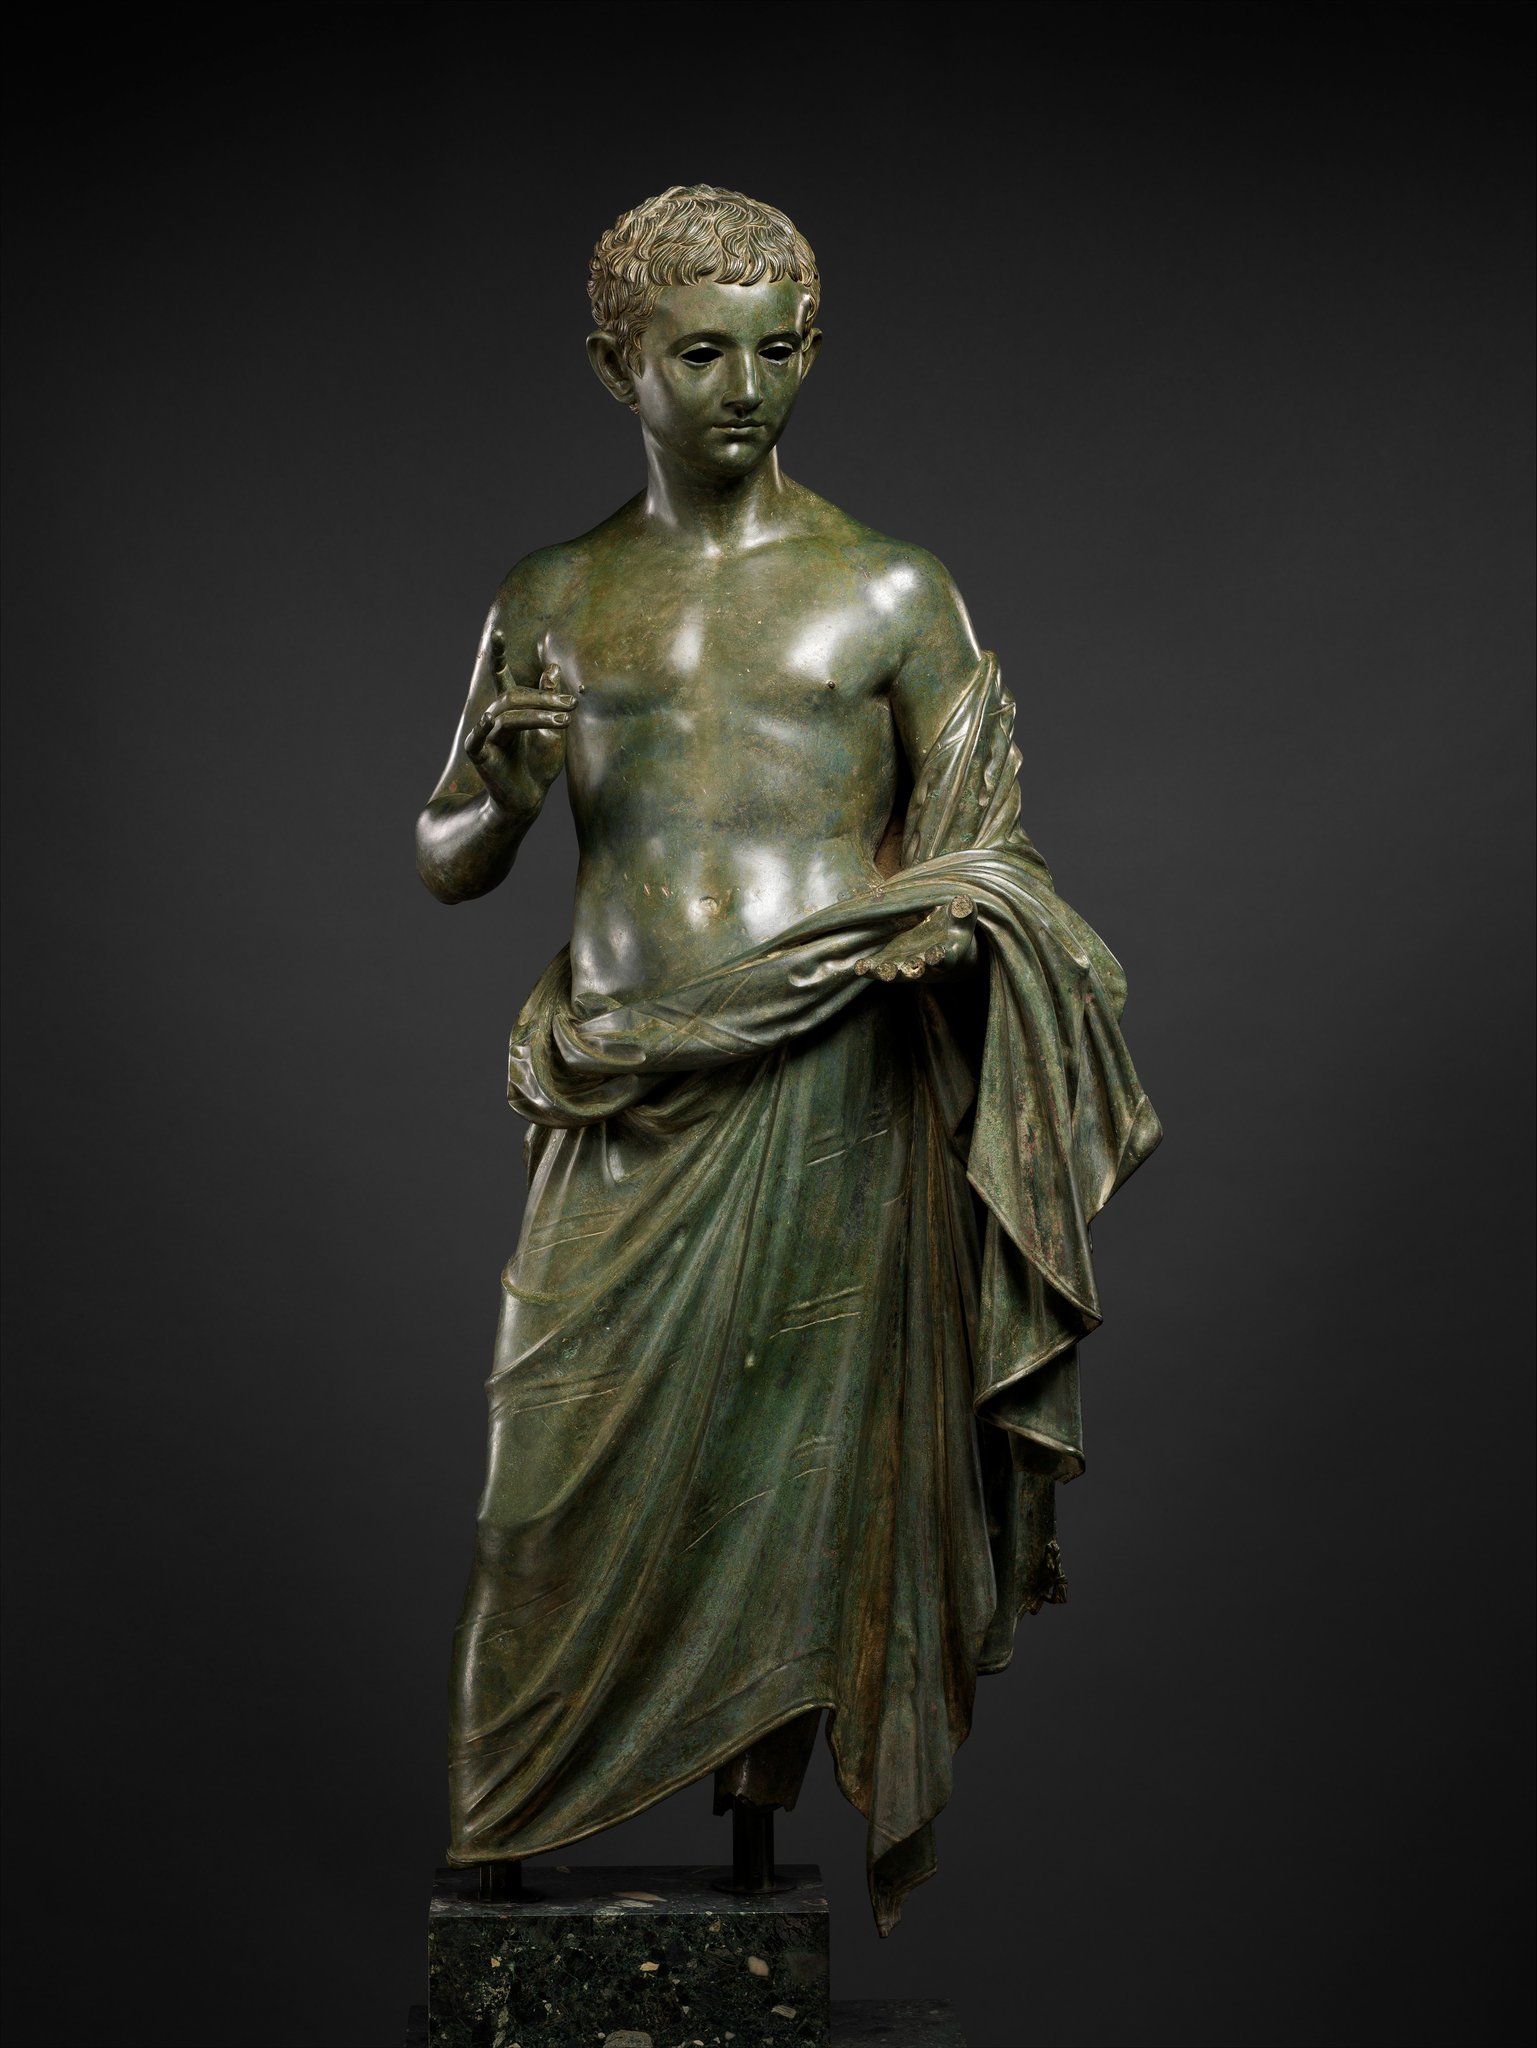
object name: statue of a boy, gaius caesar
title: Bronze statue of an aristocratic boy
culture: roman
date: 27 BCE-14 CE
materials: bronze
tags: boys